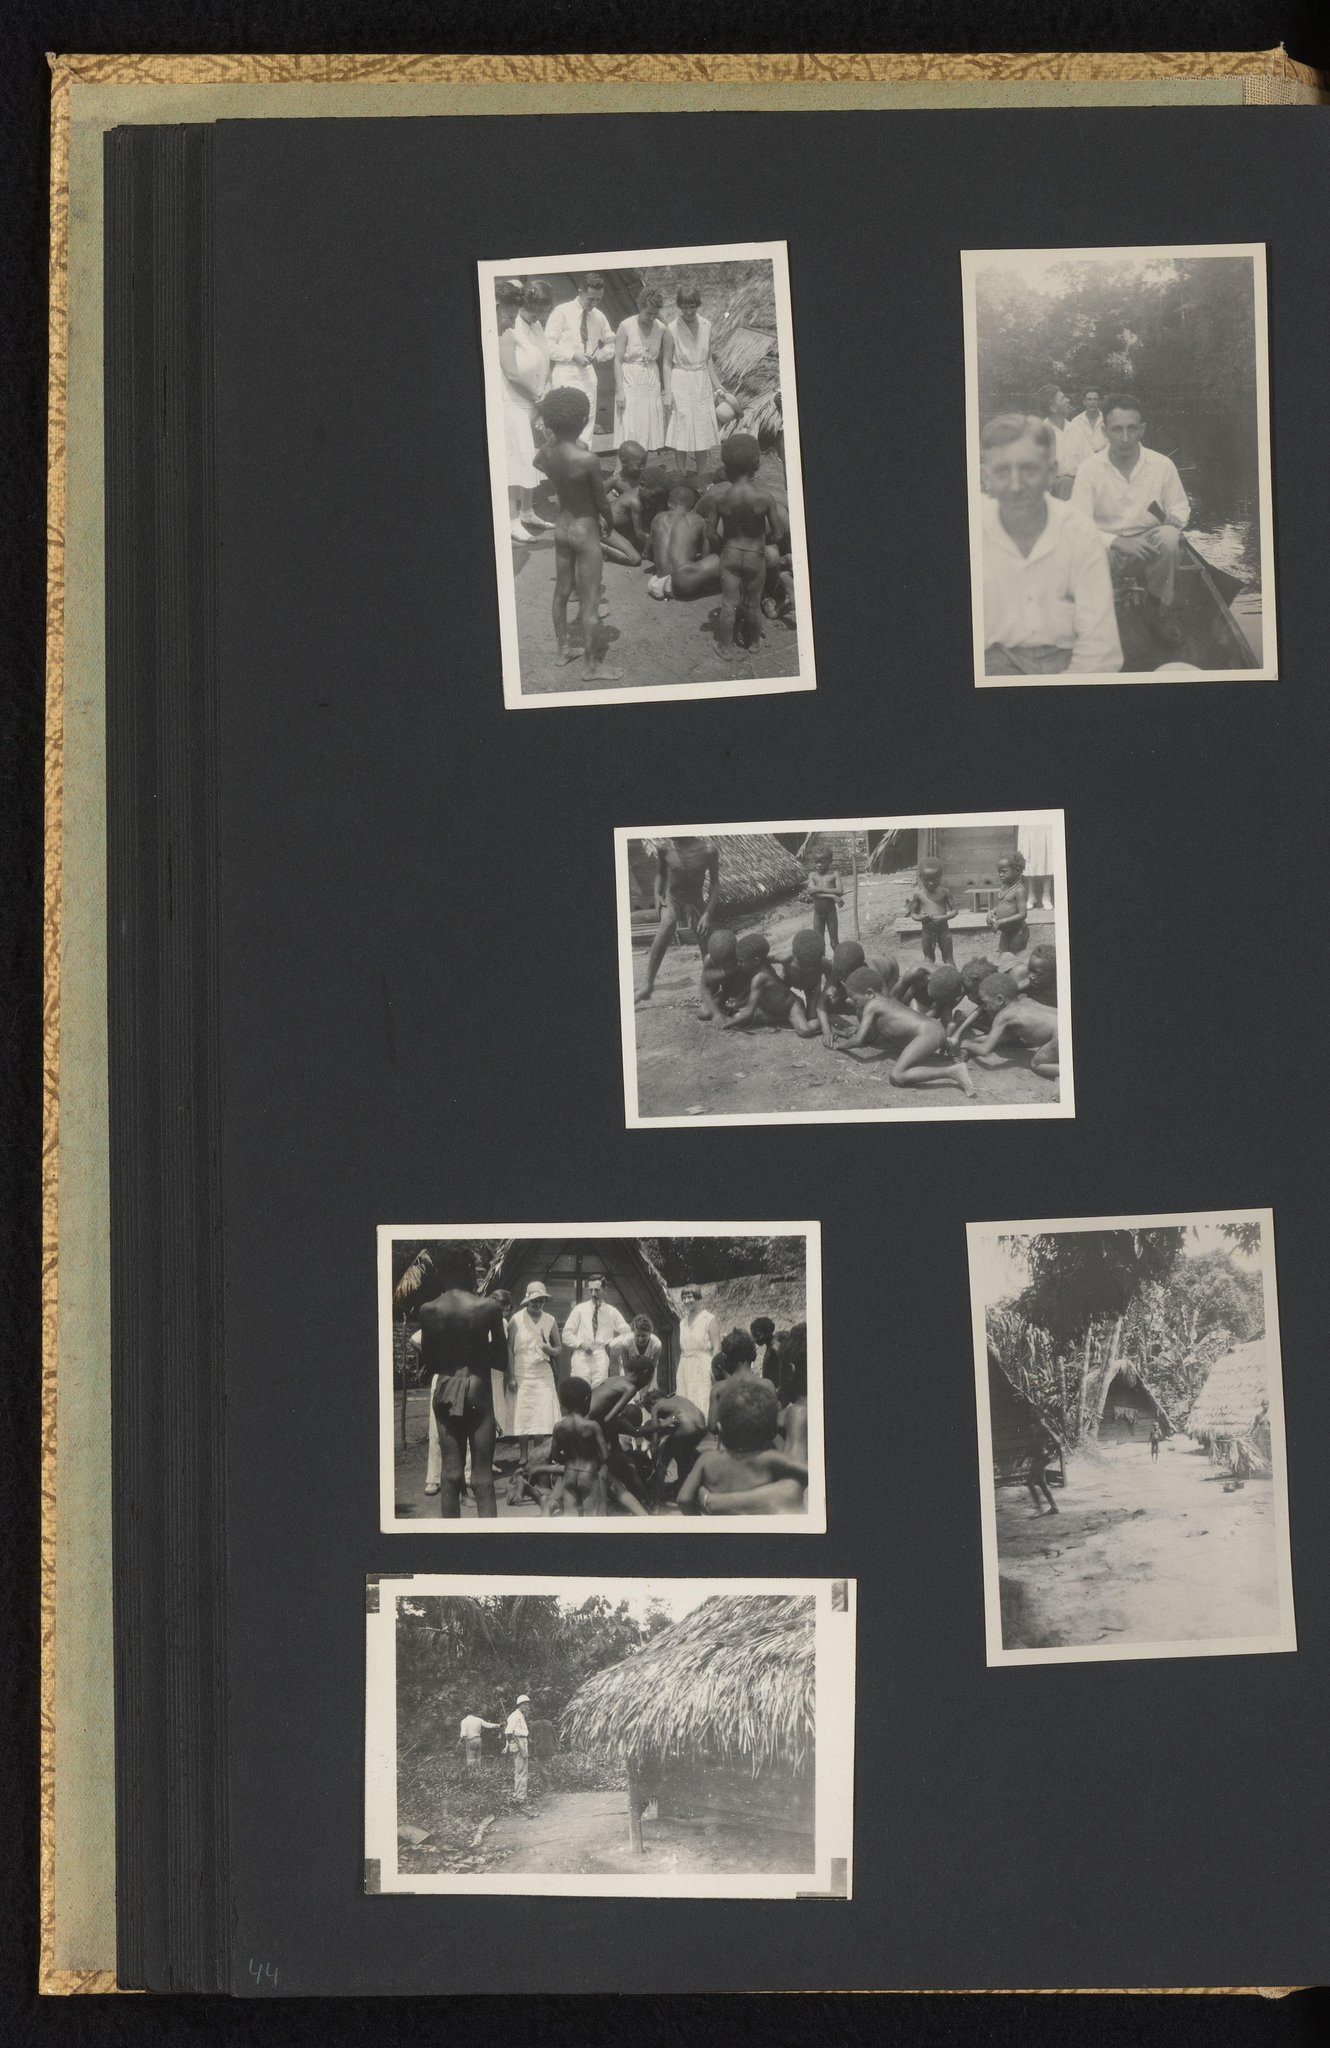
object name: album leaf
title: Bezoek aan een dorp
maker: Anonymous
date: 1927-1931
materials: paper, photographic support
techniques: gelatin silver print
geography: suriname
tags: village, suriname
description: Albumblad met zes foto's van een bezoek gebracht door een groep Europeanen aan een Surinaams dorp. Onderdeel van het album van de familie Guilonard over de bauxietwinning in Moengo en Albina in Suriname in de jaren 1929-1930.